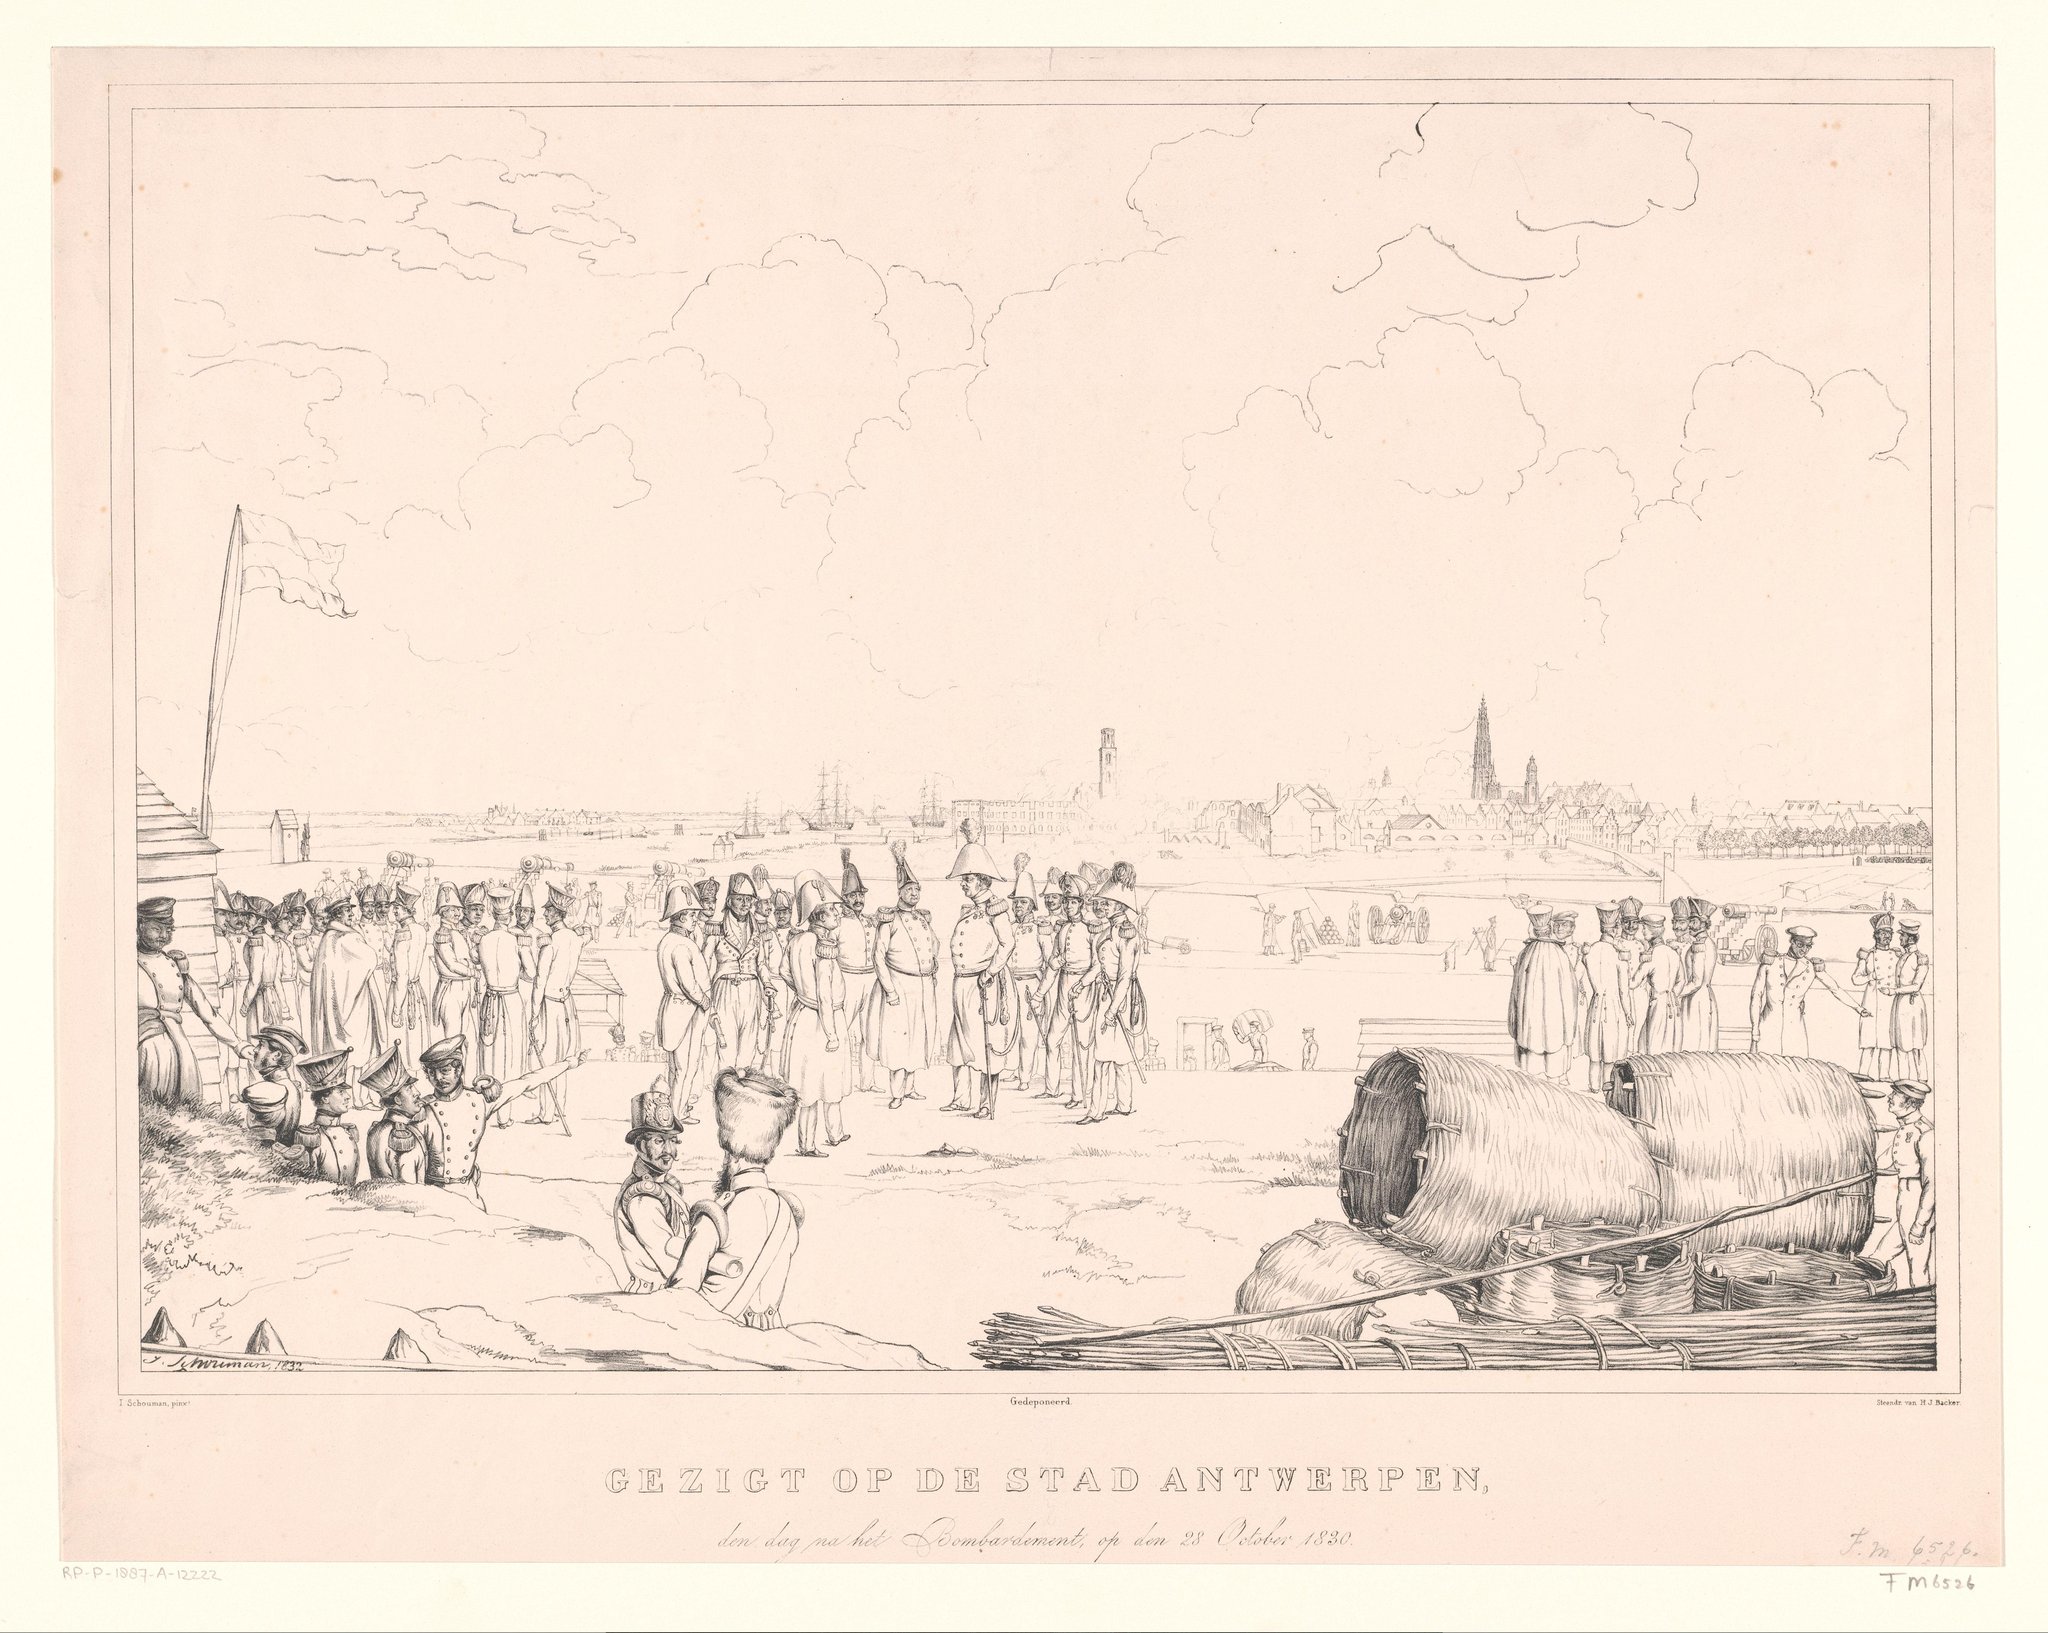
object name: print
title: Gezicht op Antwerpen vanaf het citadel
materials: paper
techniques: lithograph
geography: dordrecht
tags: david hendrik baron chassé, karel bernhard (hertog van saksen-weimar-eisenach), fortress, antwerp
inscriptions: : ‘Gedeponeerd.’, collector's mark: Lugt 2228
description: Generaal Chassé omringd door de leden van de Raad van Defensie der Citadel, staande in de Citadel van Antwerpen, op 28 oktober 1830 daags na het bombardement van de stad. De hertog van Saxen-Weimar brengt aan Chassé verslag uit van het bombardement. Op de achtergrond de stad met links het nog smeulende entrepot. Bij de prent behoort een sleutel.